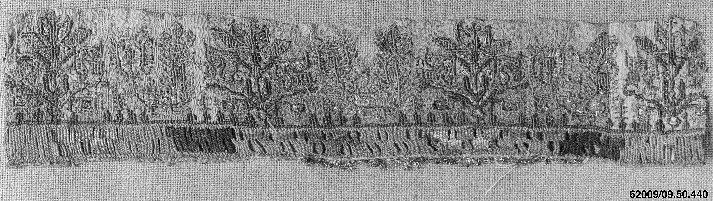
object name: towel end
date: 1801-1900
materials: linen, metal thread, silk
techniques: embroidery, weave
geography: syria